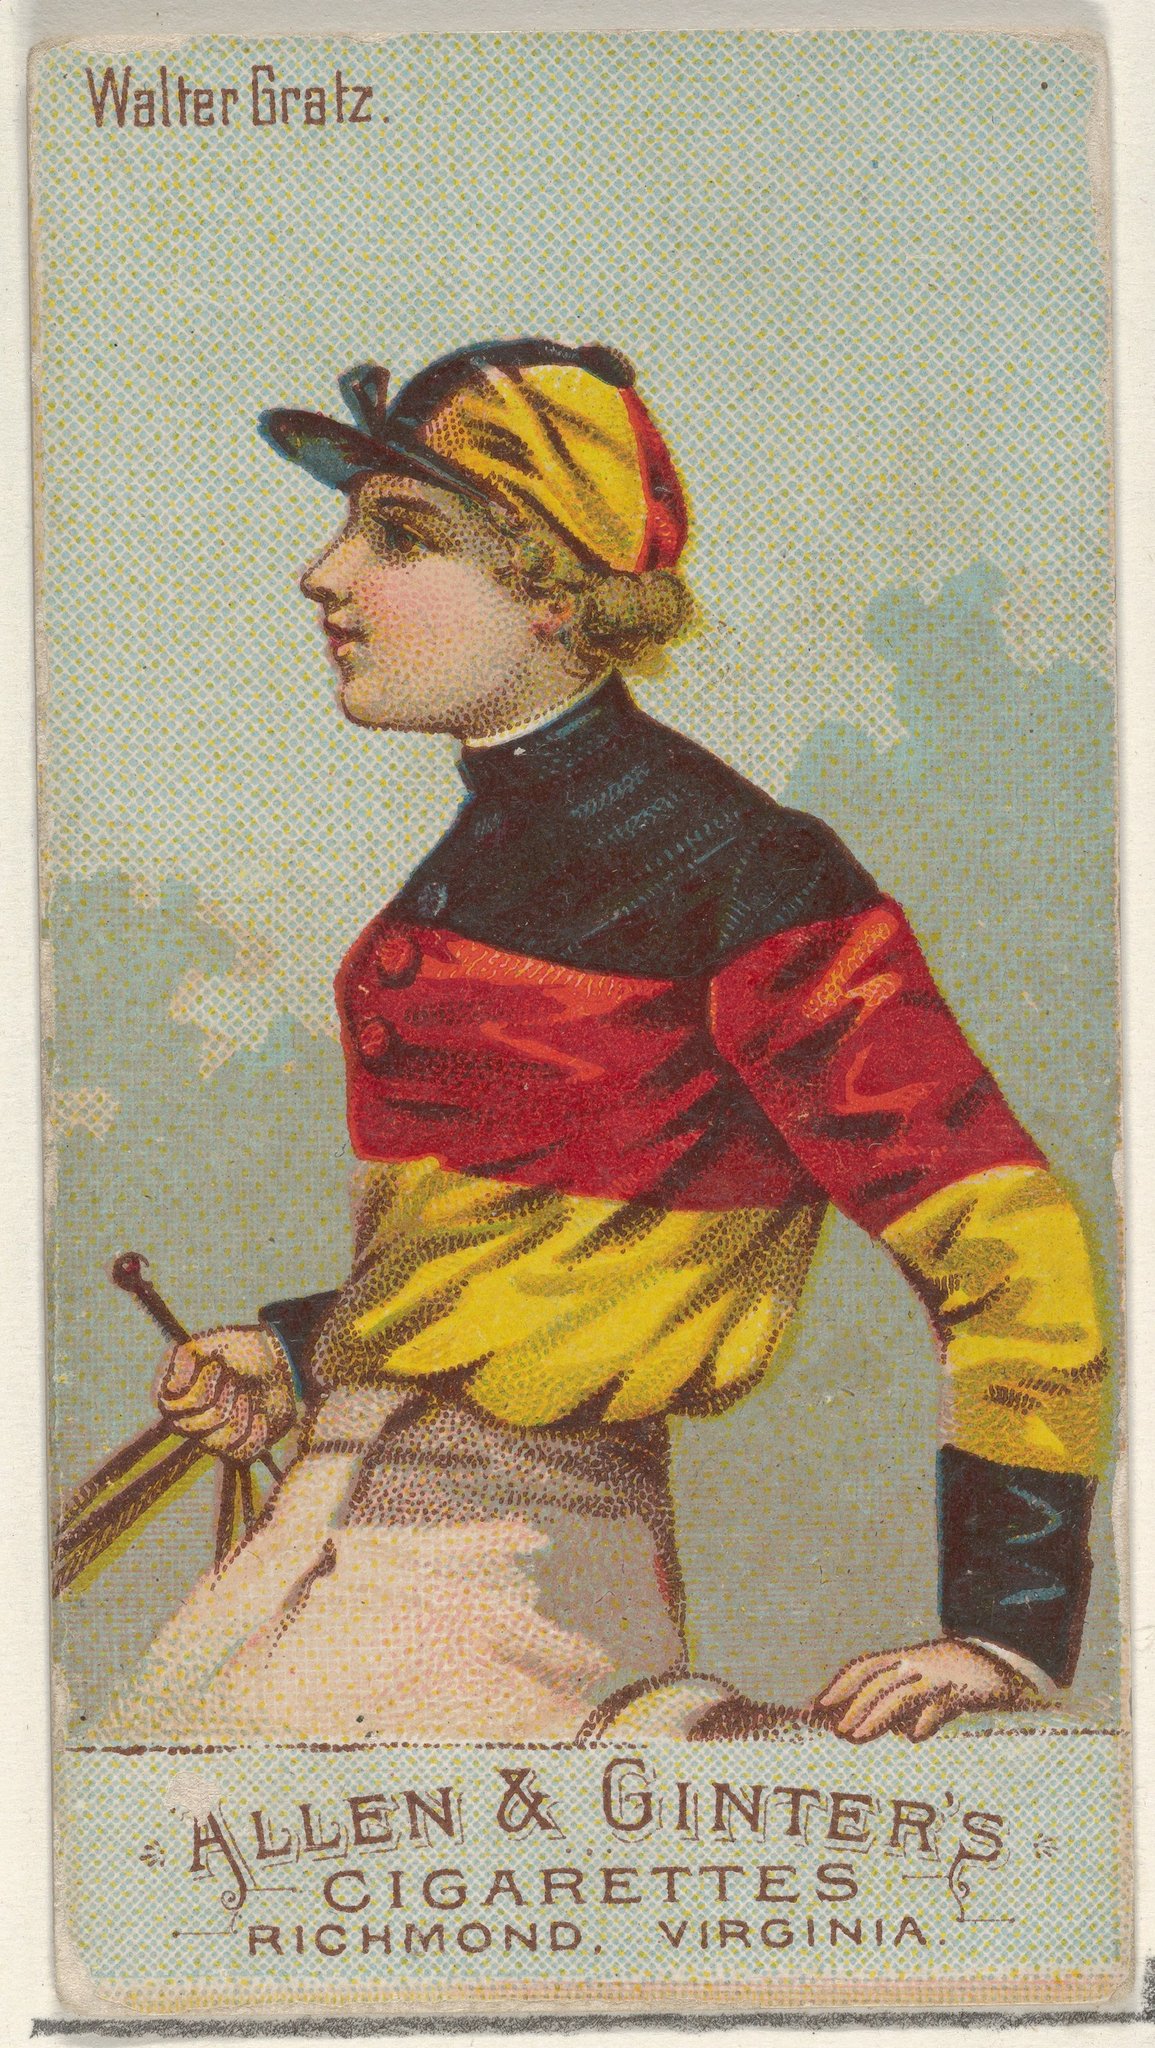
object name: print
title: Walter Gratz, from the Racing Colors of the World series (N22b) for Allen & Ginter Cigarettes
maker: allen & ginter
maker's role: publisher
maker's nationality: american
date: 1888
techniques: color lithograph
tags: profiles,women